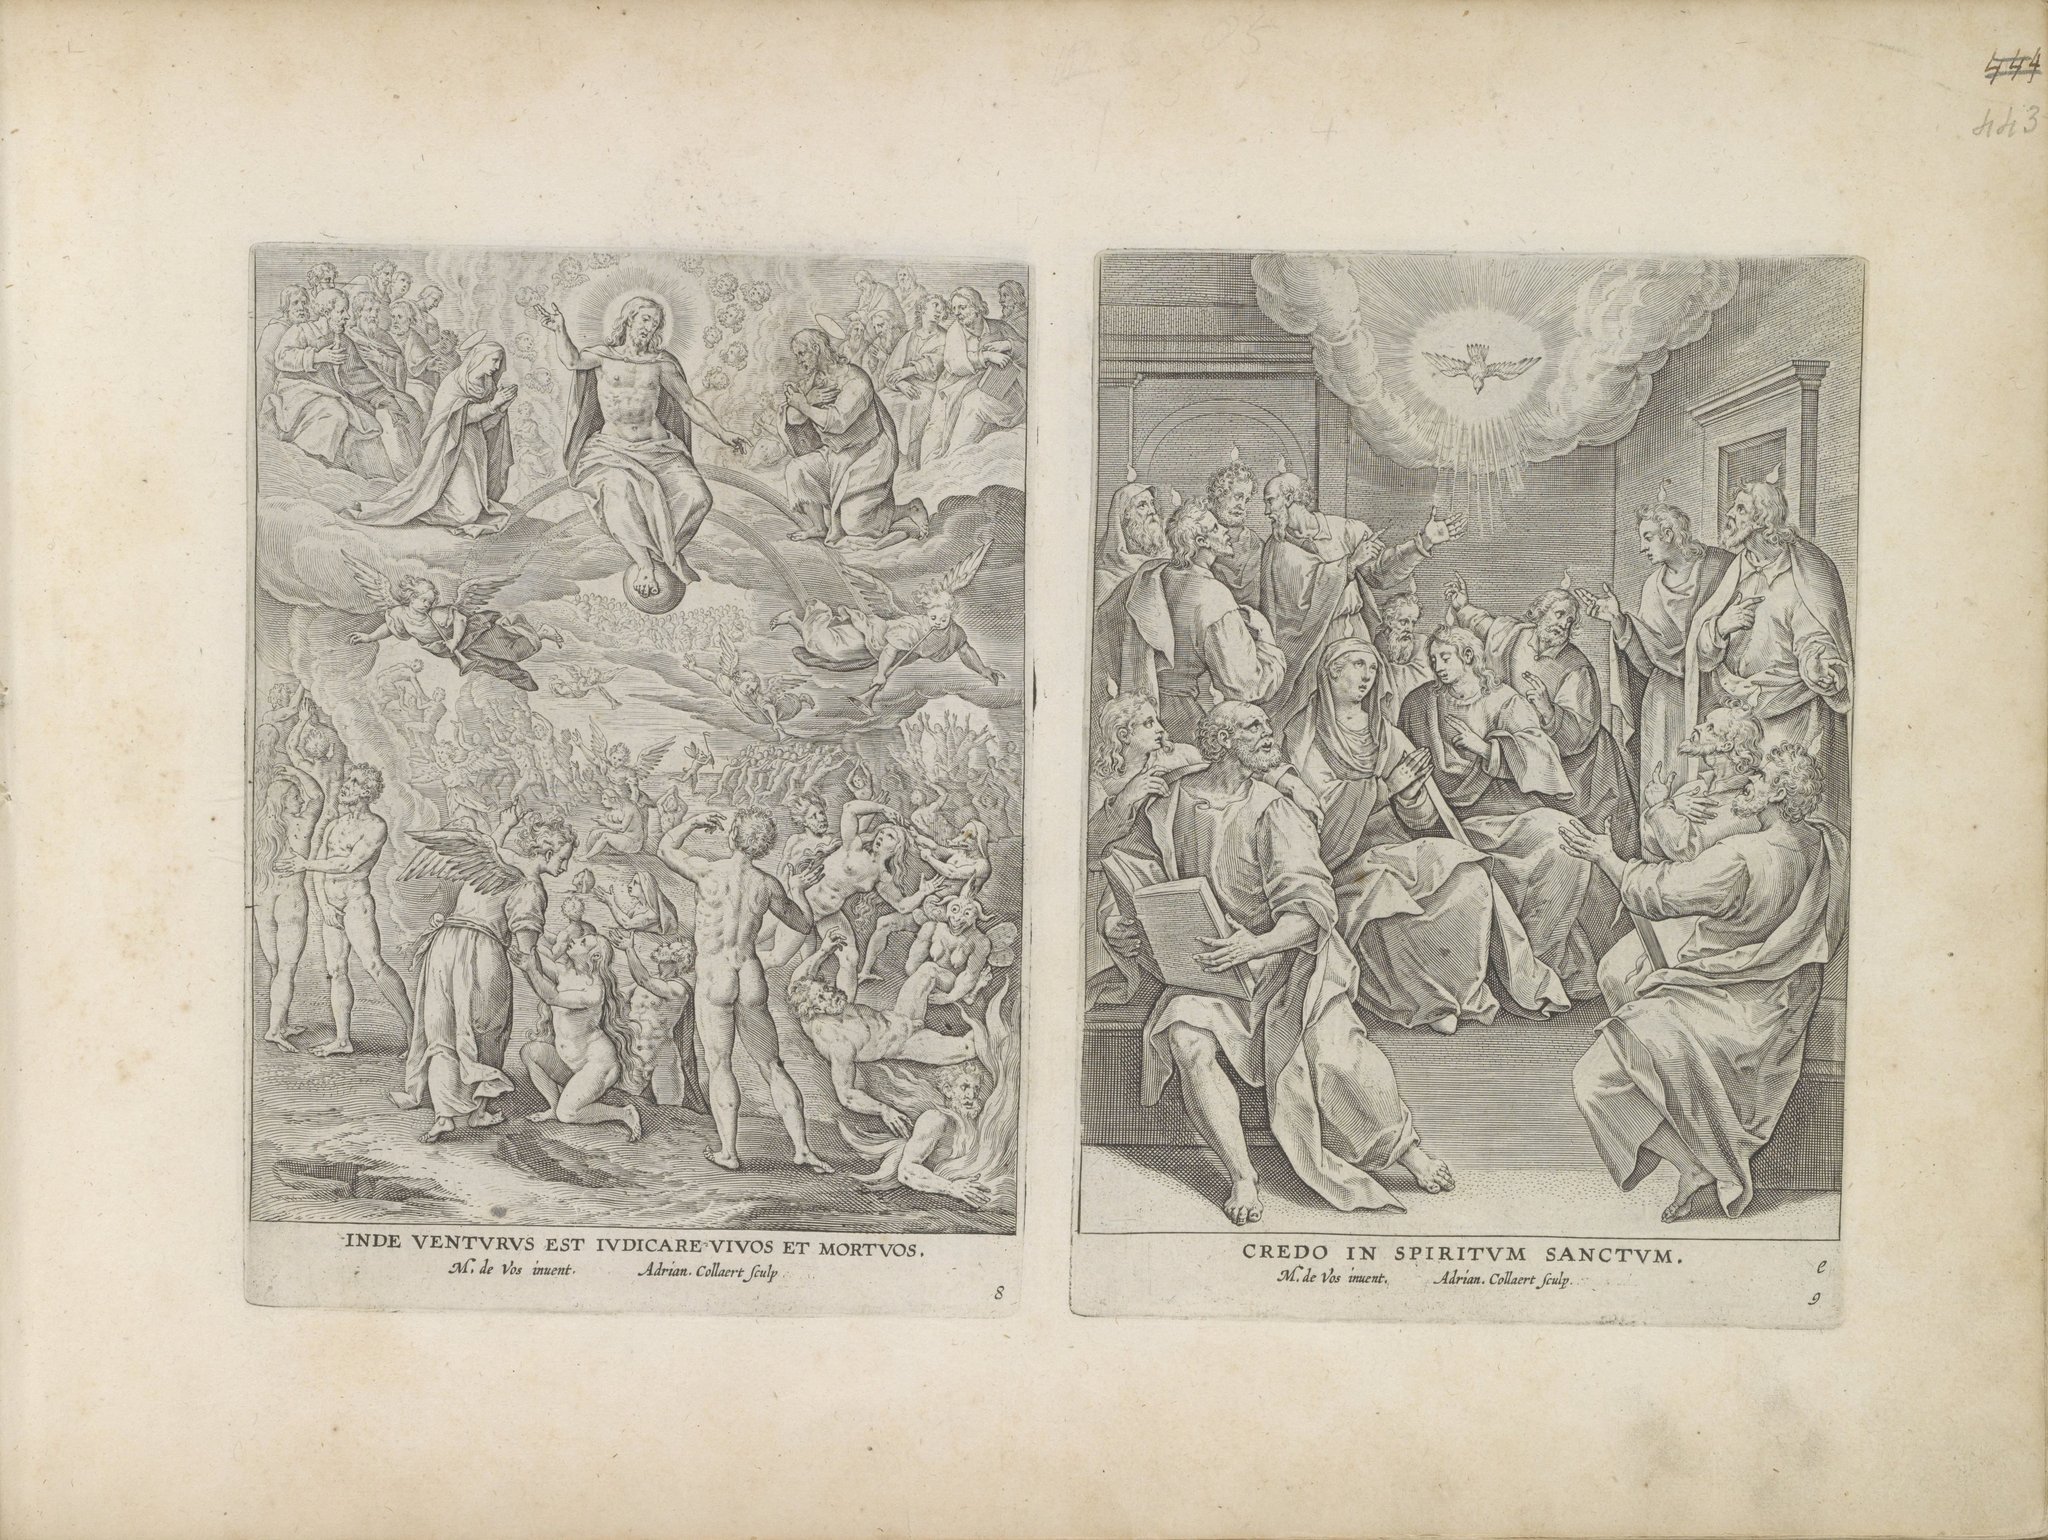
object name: album leaf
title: Theatrum Biblicum Hoc Est Historiae Sacrae Veteris et Novi Testamenti Tabulis Aeneis Expressae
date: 1570-1618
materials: paper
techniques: engraving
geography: amsterdam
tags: 'credo in spiritum sanctum' ~ articles of faith, pentecost: the holy ghost descends upon (mary and) the apostles, sometimes paul and/or representatives of the nations present (acts 2:1-4)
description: Illustratie van het achtste geloofsartikel (Ik geloof in de heilige Geest) van de apostolische geloofsbelijdenis. Maria en de twaalf apostelen zitten in een kamervertrek. Vurige tongen branden boven hun hoofden. De Heilige Geest, in de gedaante van een duif, zweeft boven de apostelen, omgeven door lichtstralen. Deze prent maakt deel uit van een album.